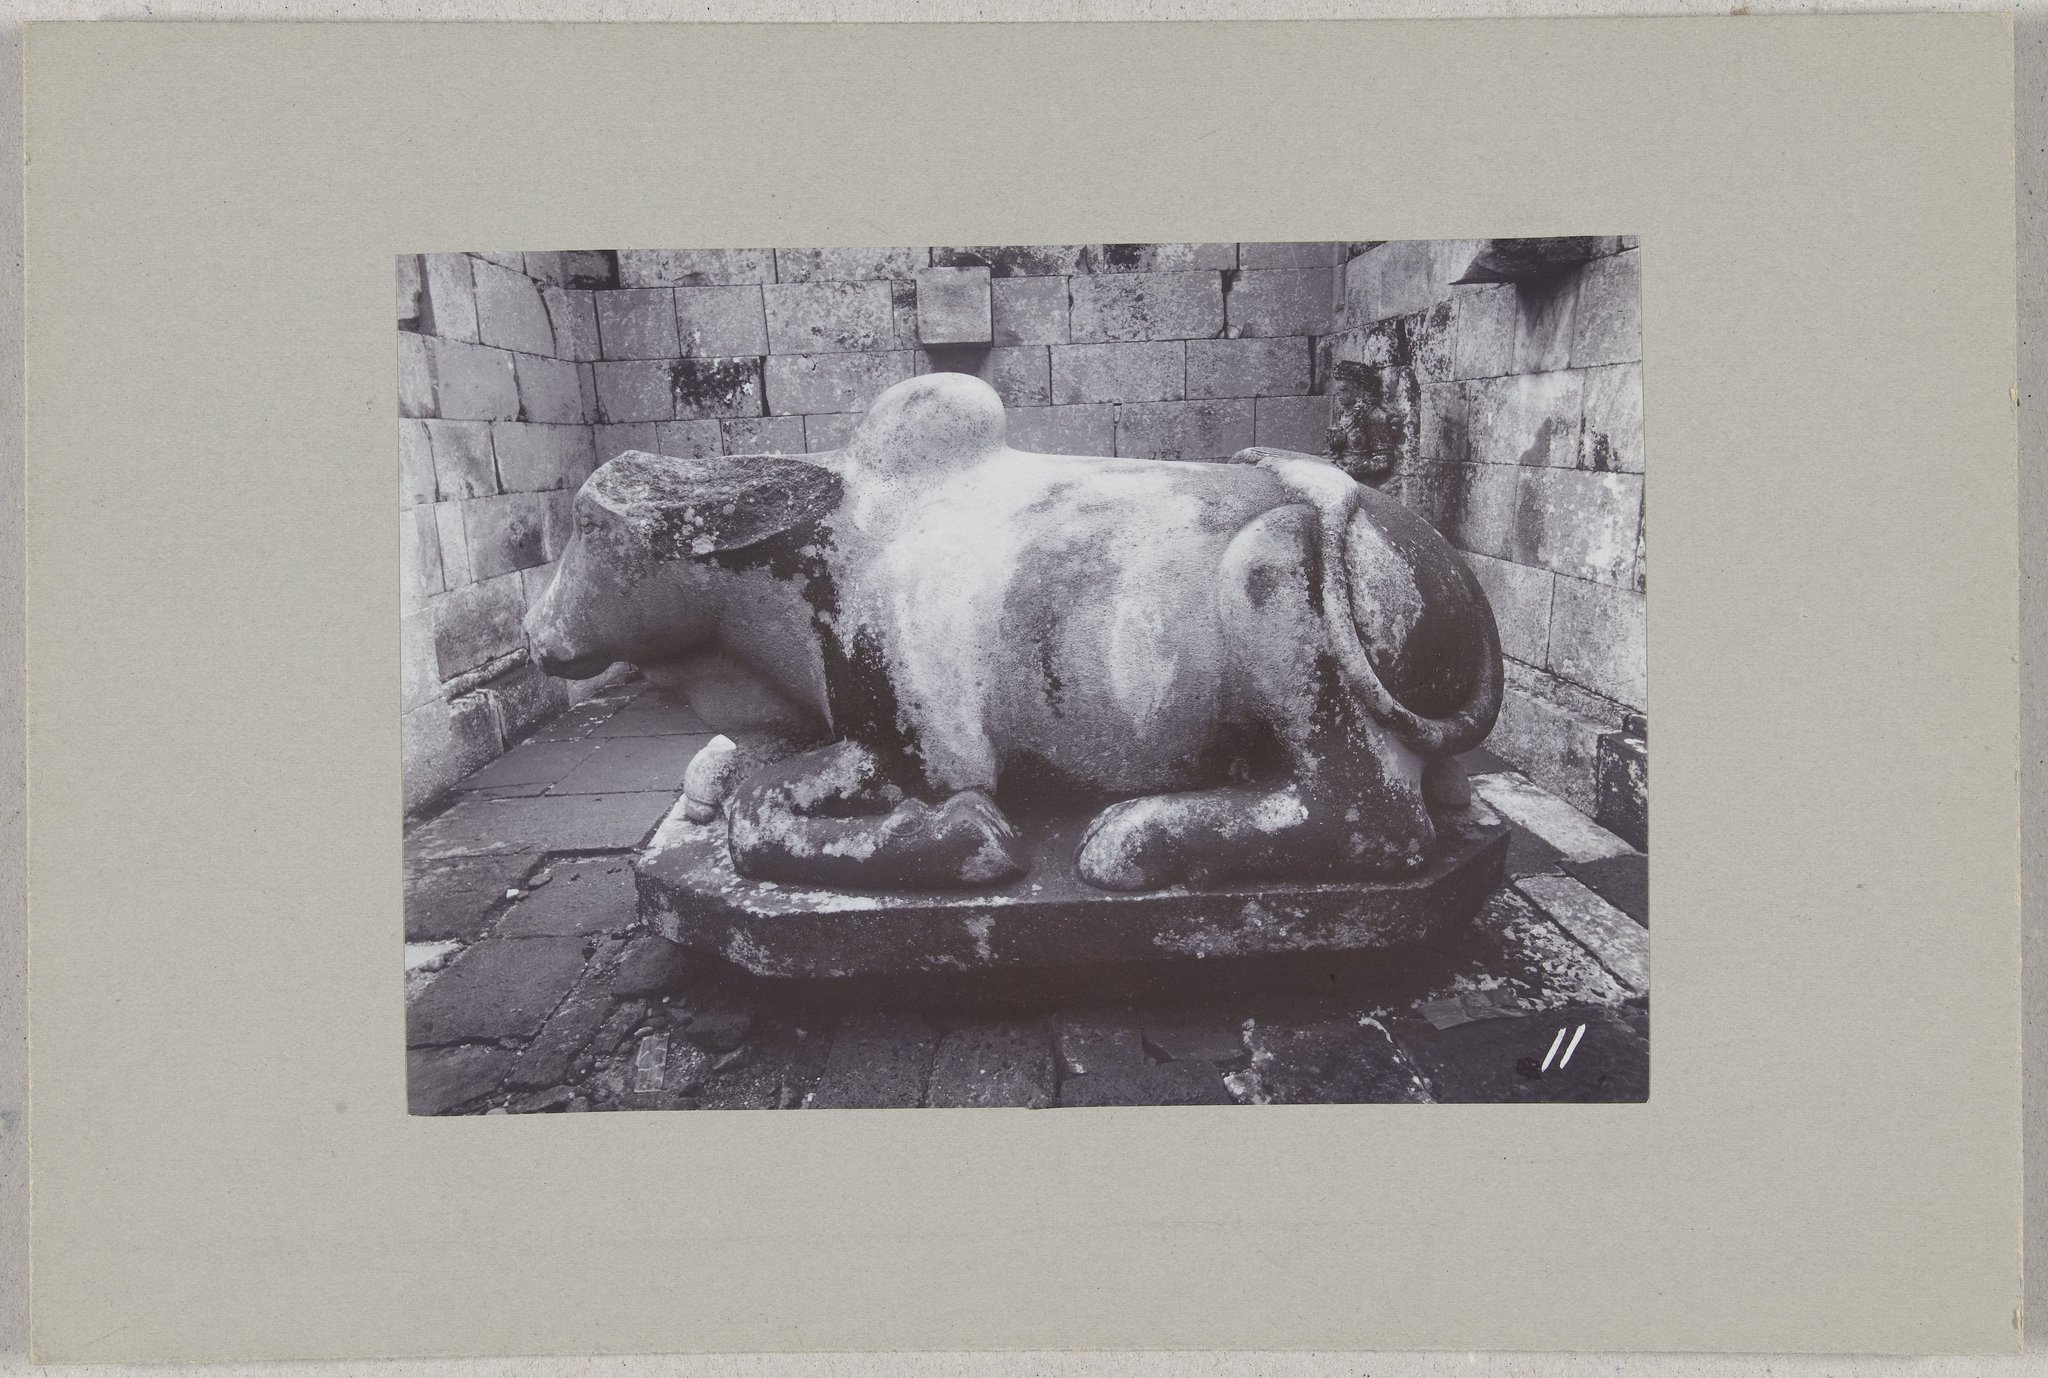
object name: photograph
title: 86b Stier in tempel b (tegenover tempel a)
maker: Anonymous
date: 1895-1915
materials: cardboard, paper, photographic support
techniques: gelatin silver print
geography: jogjakarta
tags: indonesia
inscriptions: annotation: ‘86b Stier in tempel b (tegenover tempel a)’, number: ‘11’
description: Beeld van een stier in een tempel van Prambanan bij Jogyakarta, Nederlands-Indië